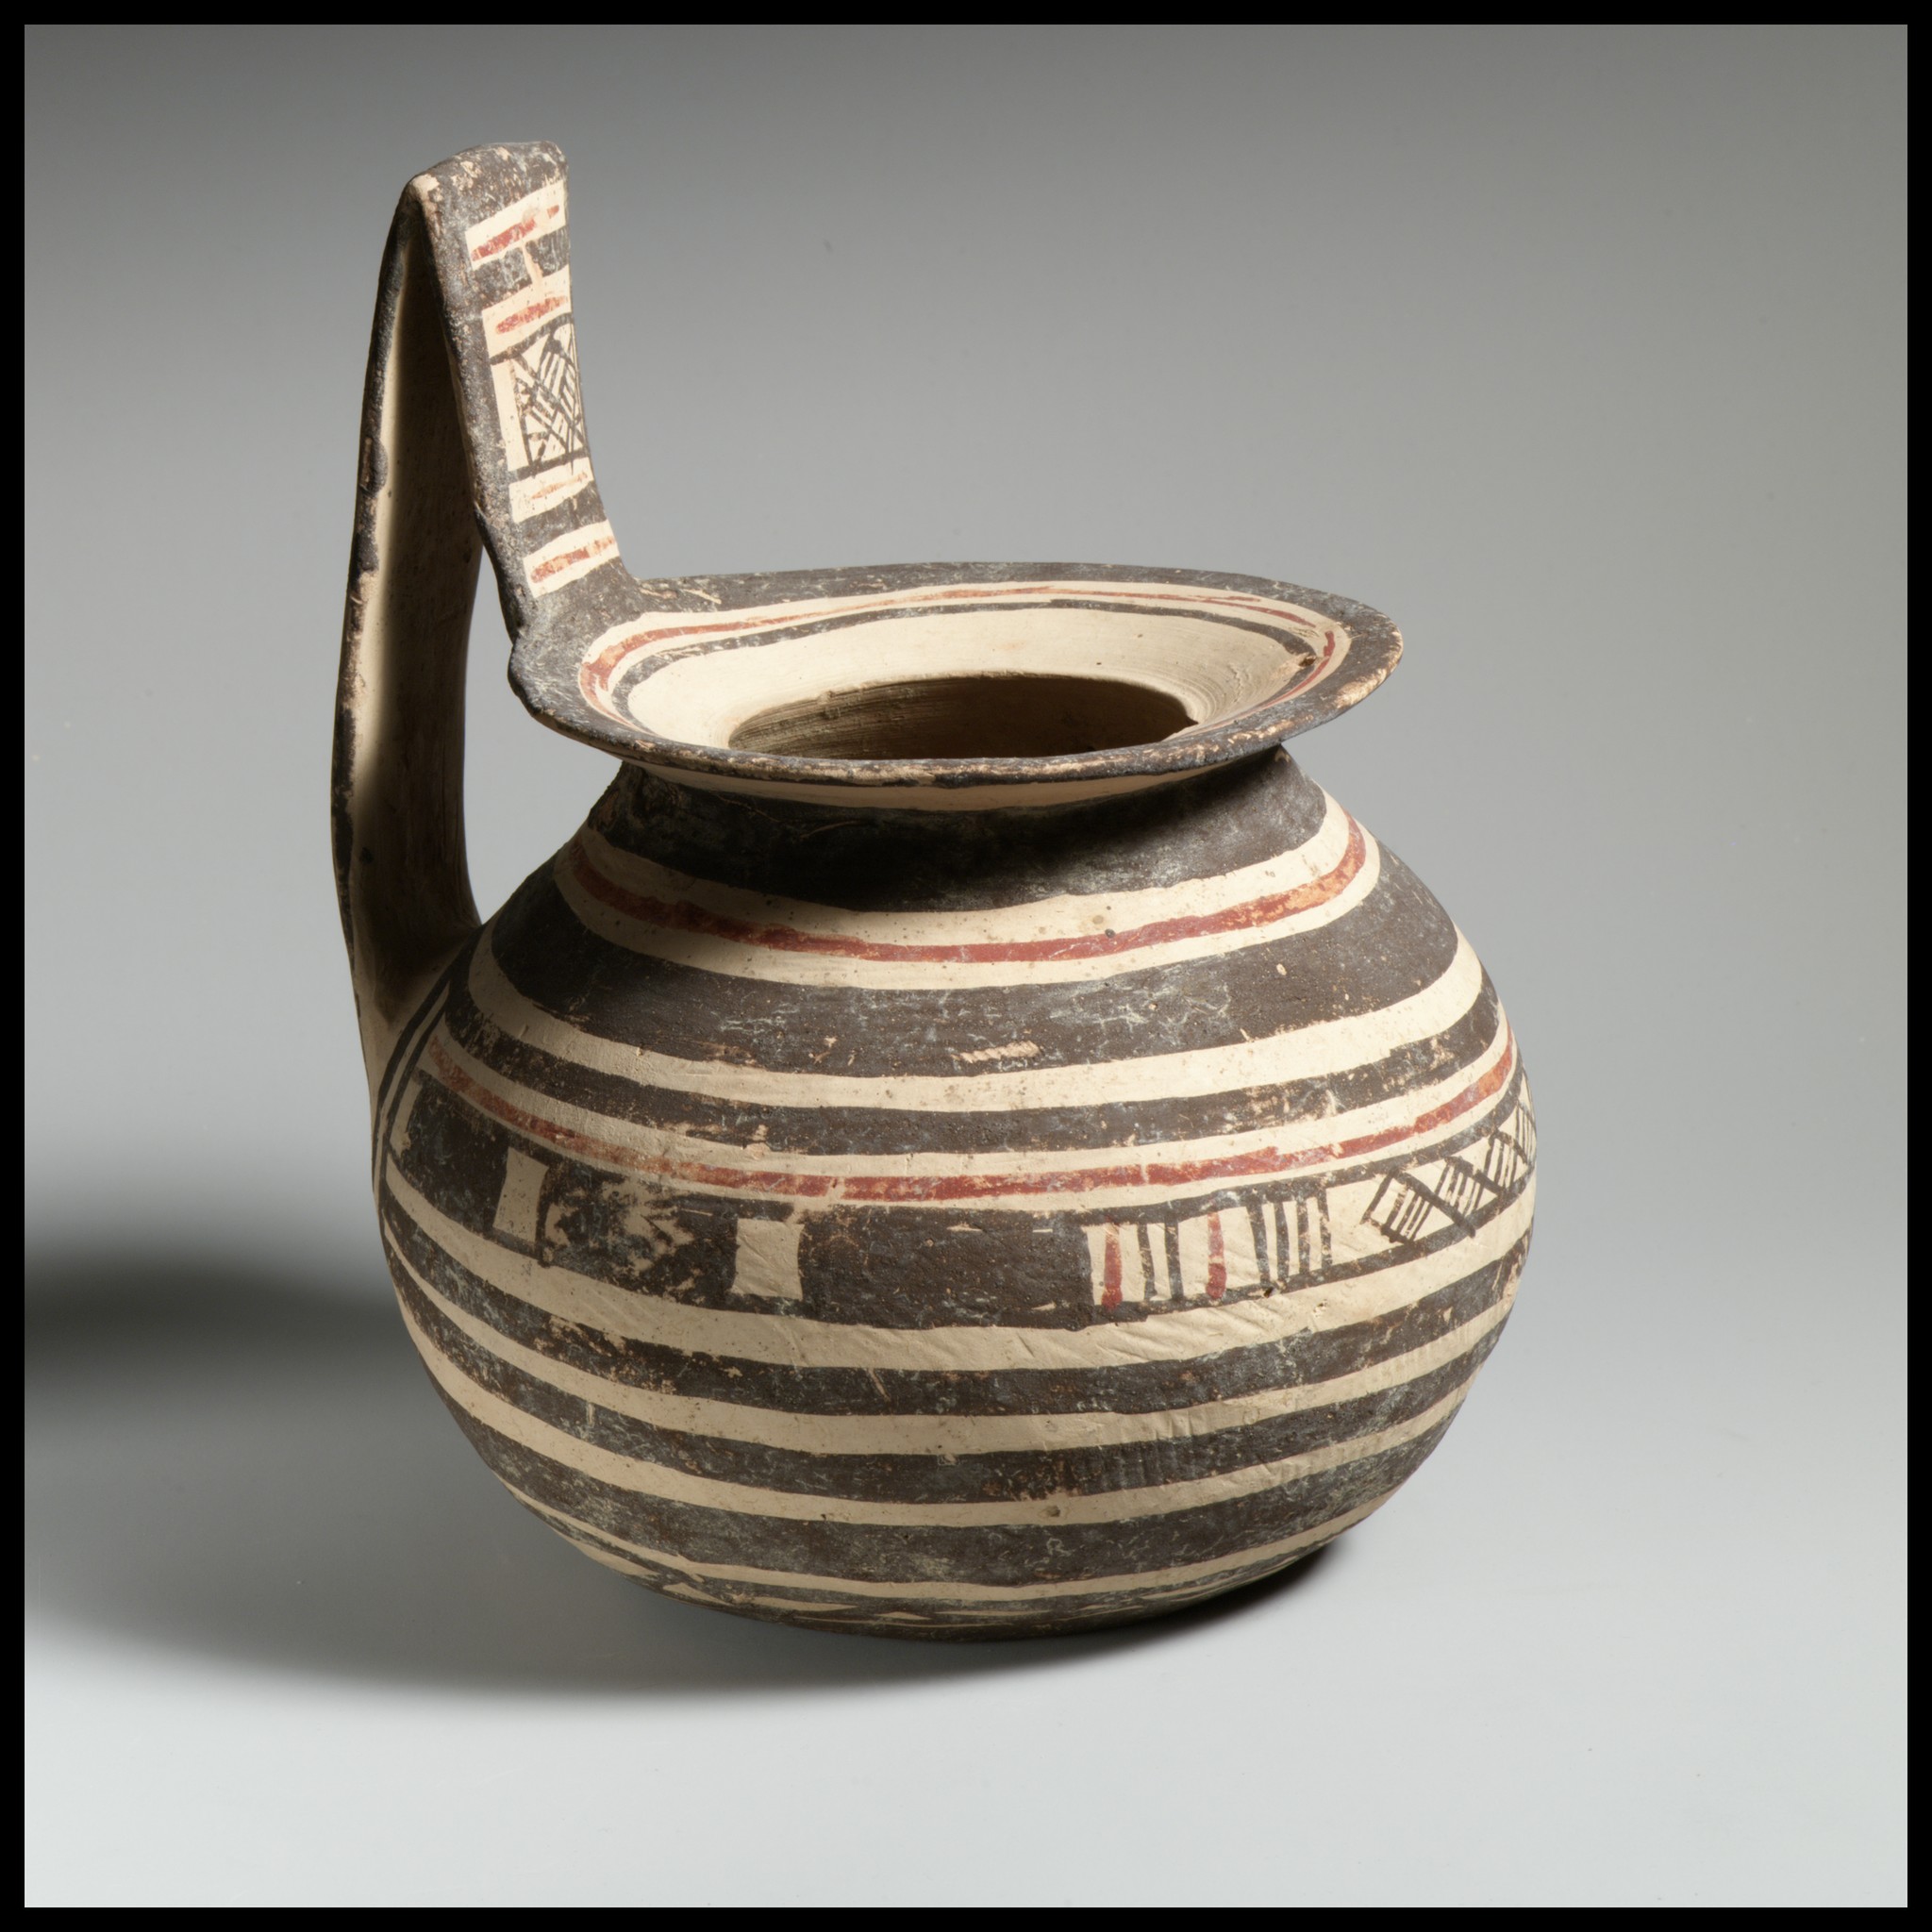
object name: jug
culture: italic, daunian or south italian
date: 900-100 BCE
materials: terracotta